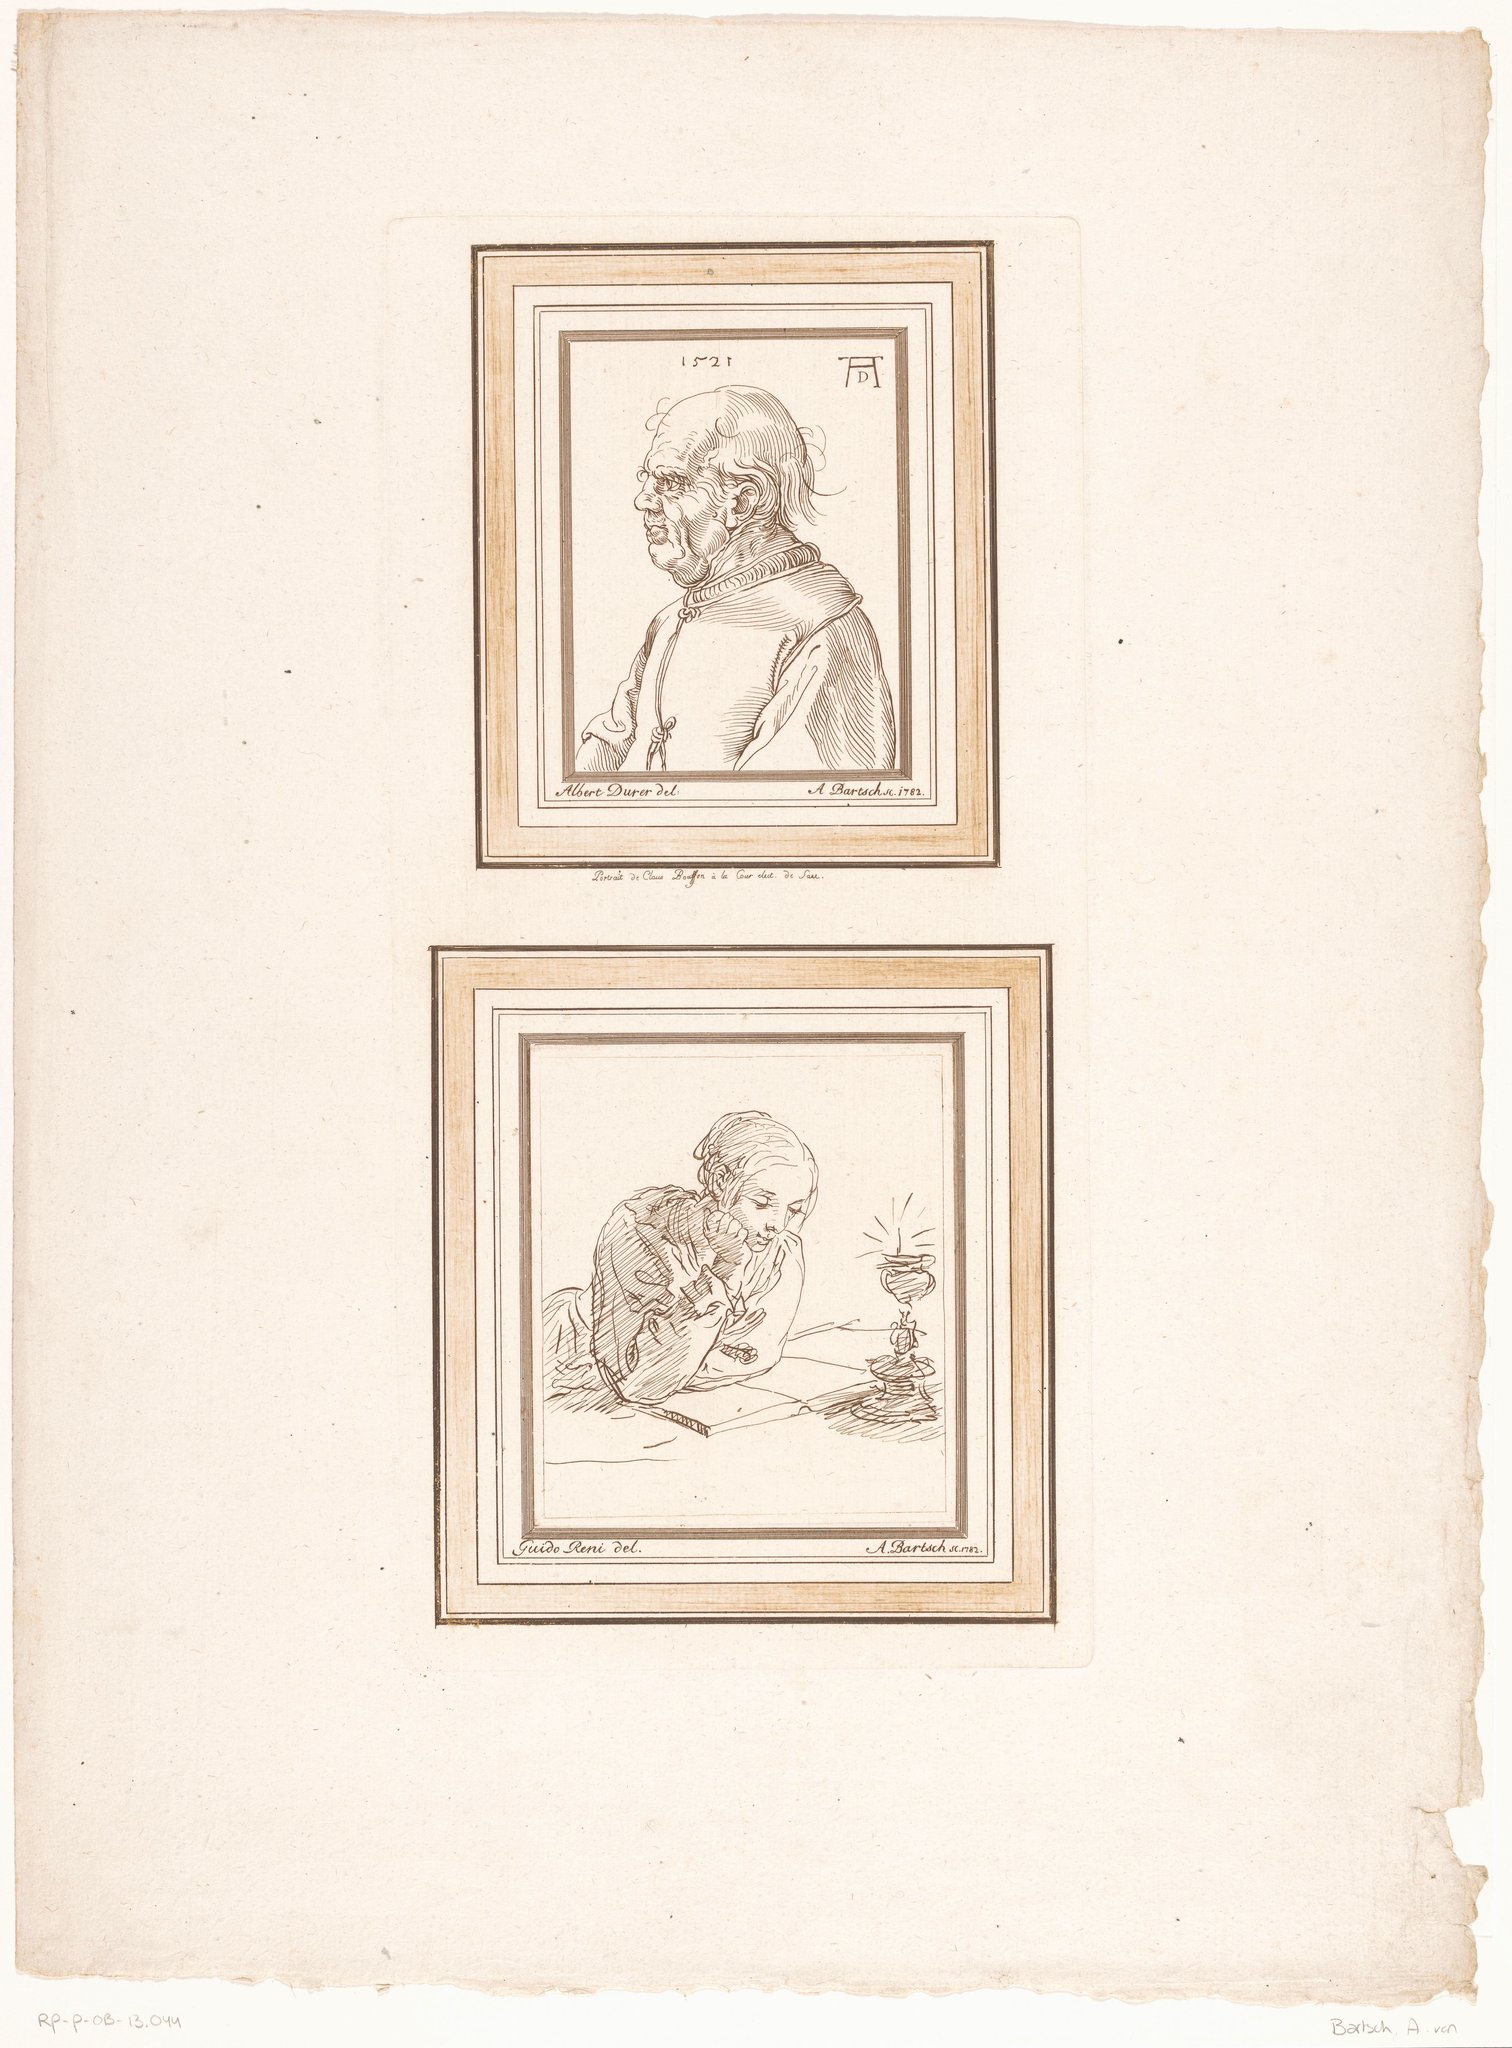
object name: print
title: Portrait de Claus Bouffon à la Cour elect. de Saxe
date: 1782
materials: paper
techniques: etching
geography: vienna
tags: court jester, court fool, reading, book, candle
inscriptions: collector's mark: Lugt 240